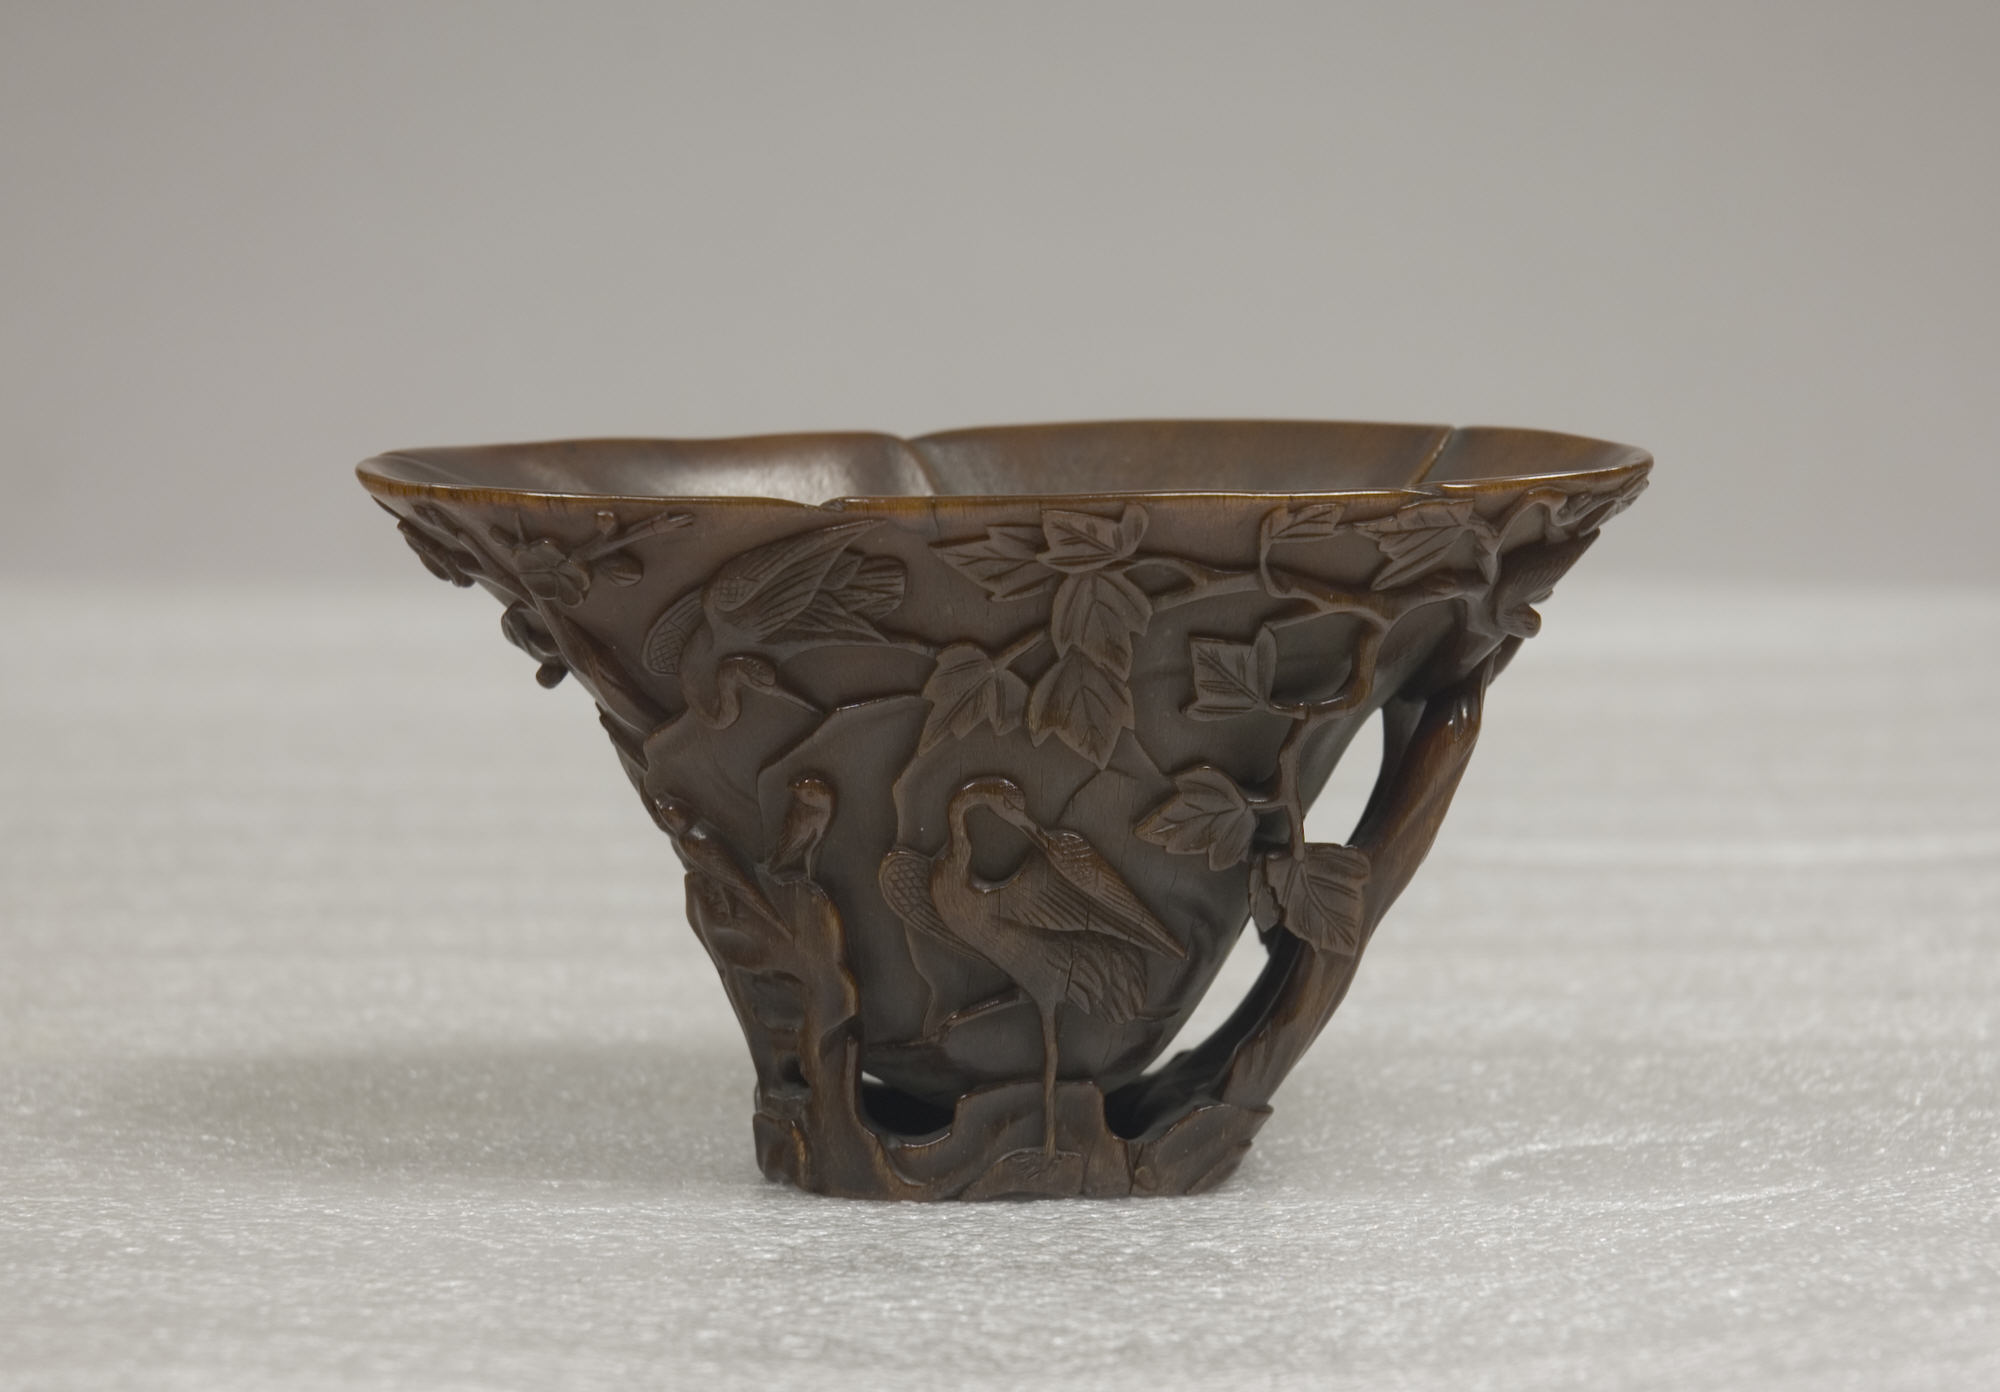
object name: cup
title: Cup with a Flower and Bird Scene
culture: chinese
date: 1701-1800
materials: horn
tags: birds,leaves